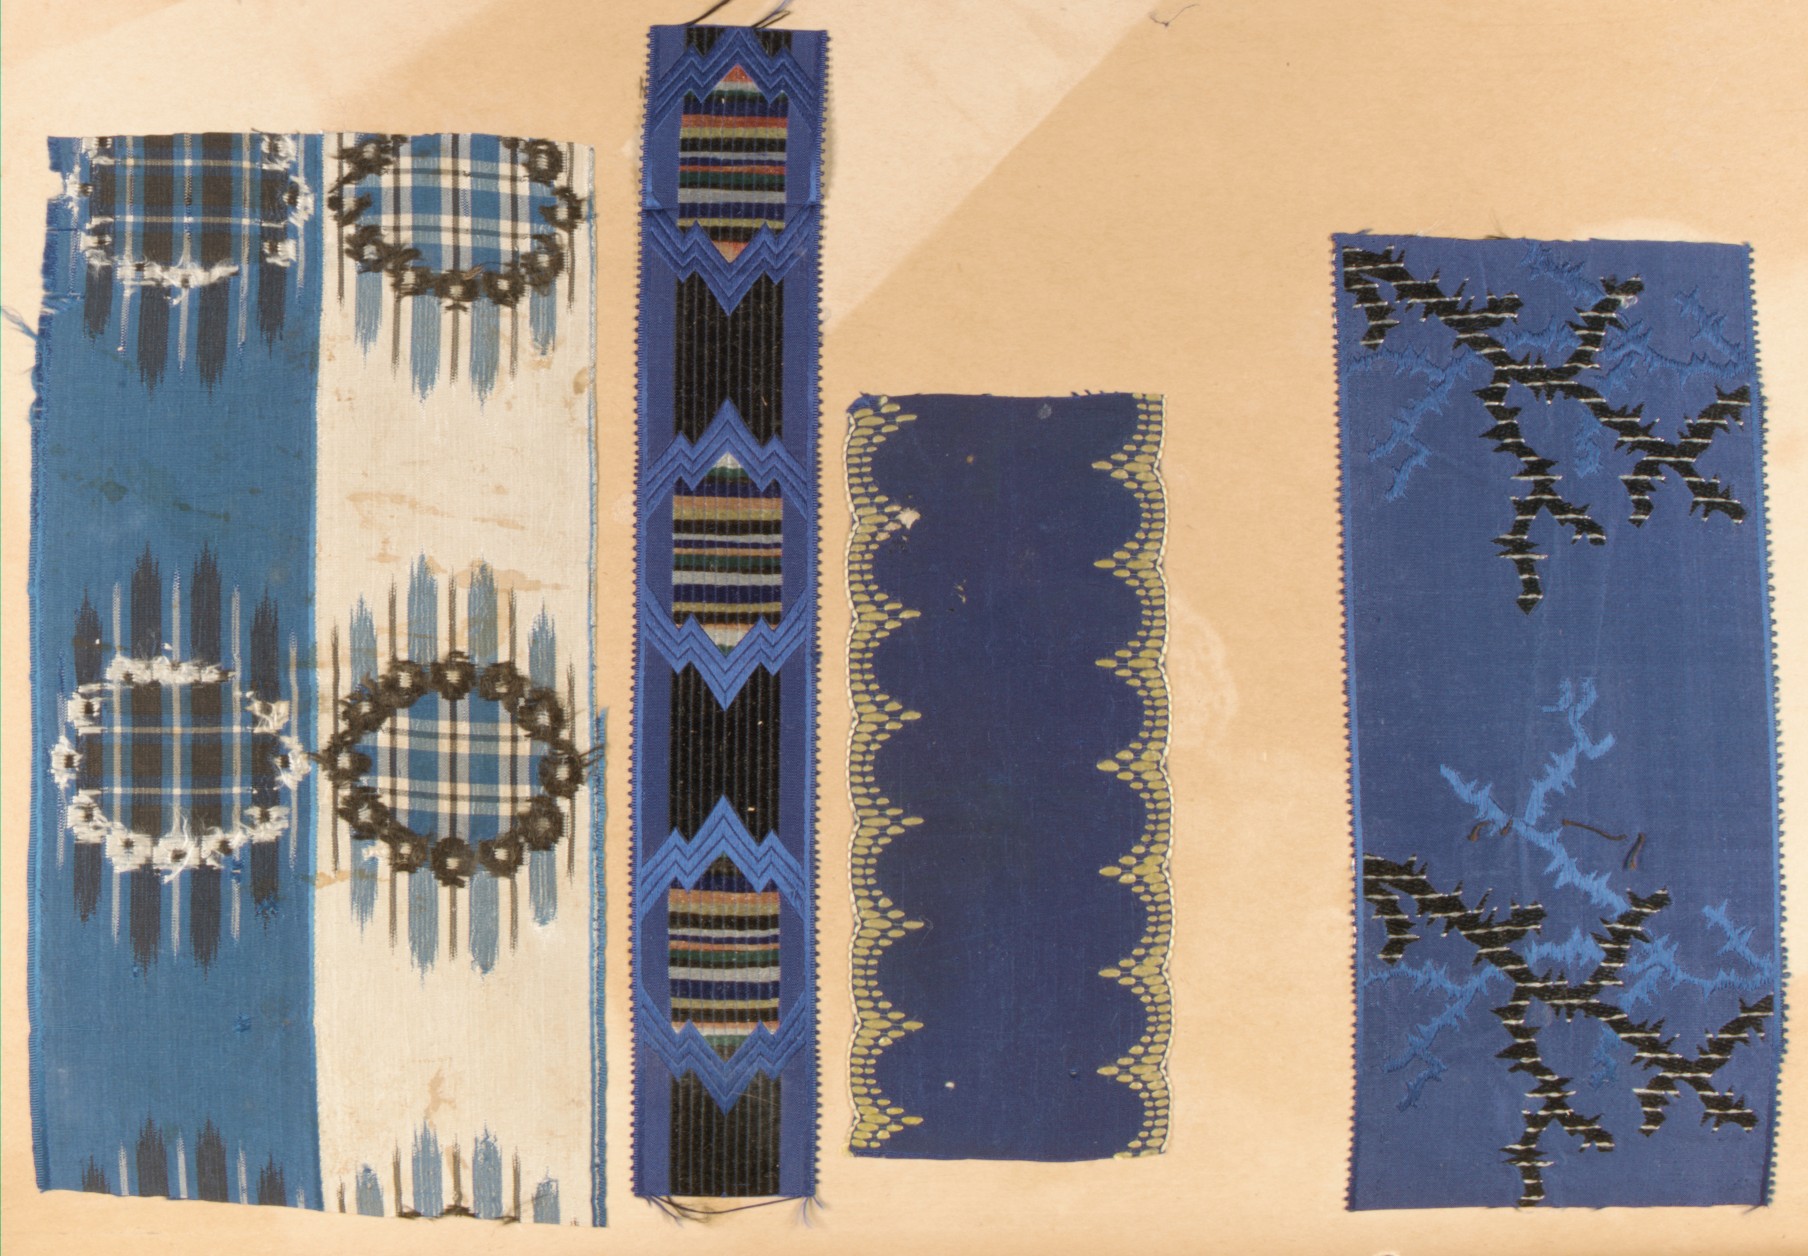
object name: sample book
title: Textile Sample Book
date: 1801-1900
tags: flowers